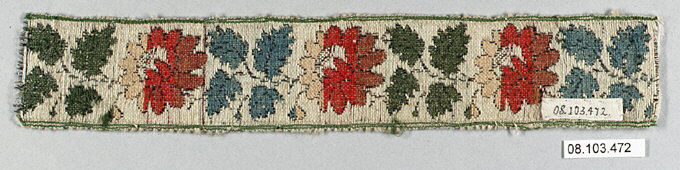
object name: galloon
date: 1801-1900